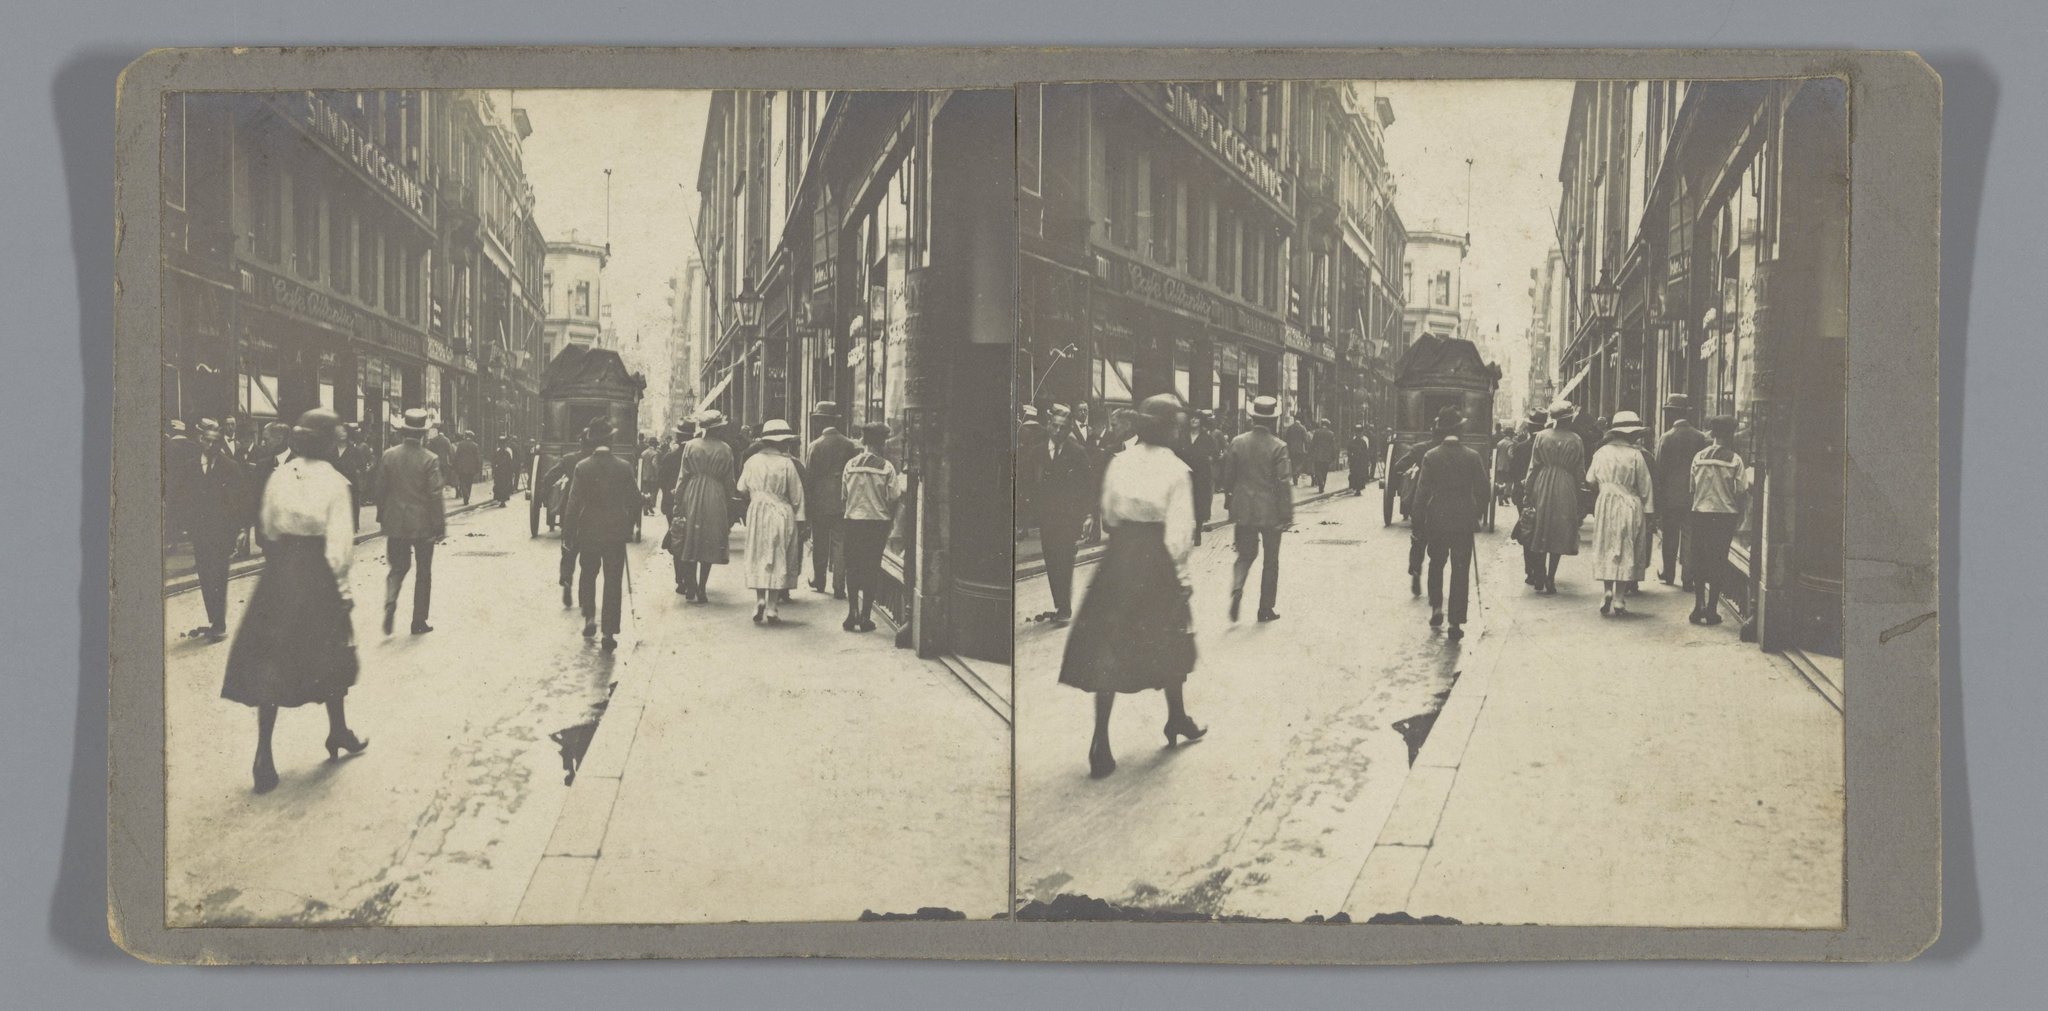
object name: stereograph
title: Voetgangers op de Hohe Straße te Keulen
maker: Anonymous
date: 1921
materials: cardboard, photographic support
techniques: gelatin silver print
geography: cologne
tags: street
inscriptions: inscription: ‘Hohe strasse Keulen 1921’